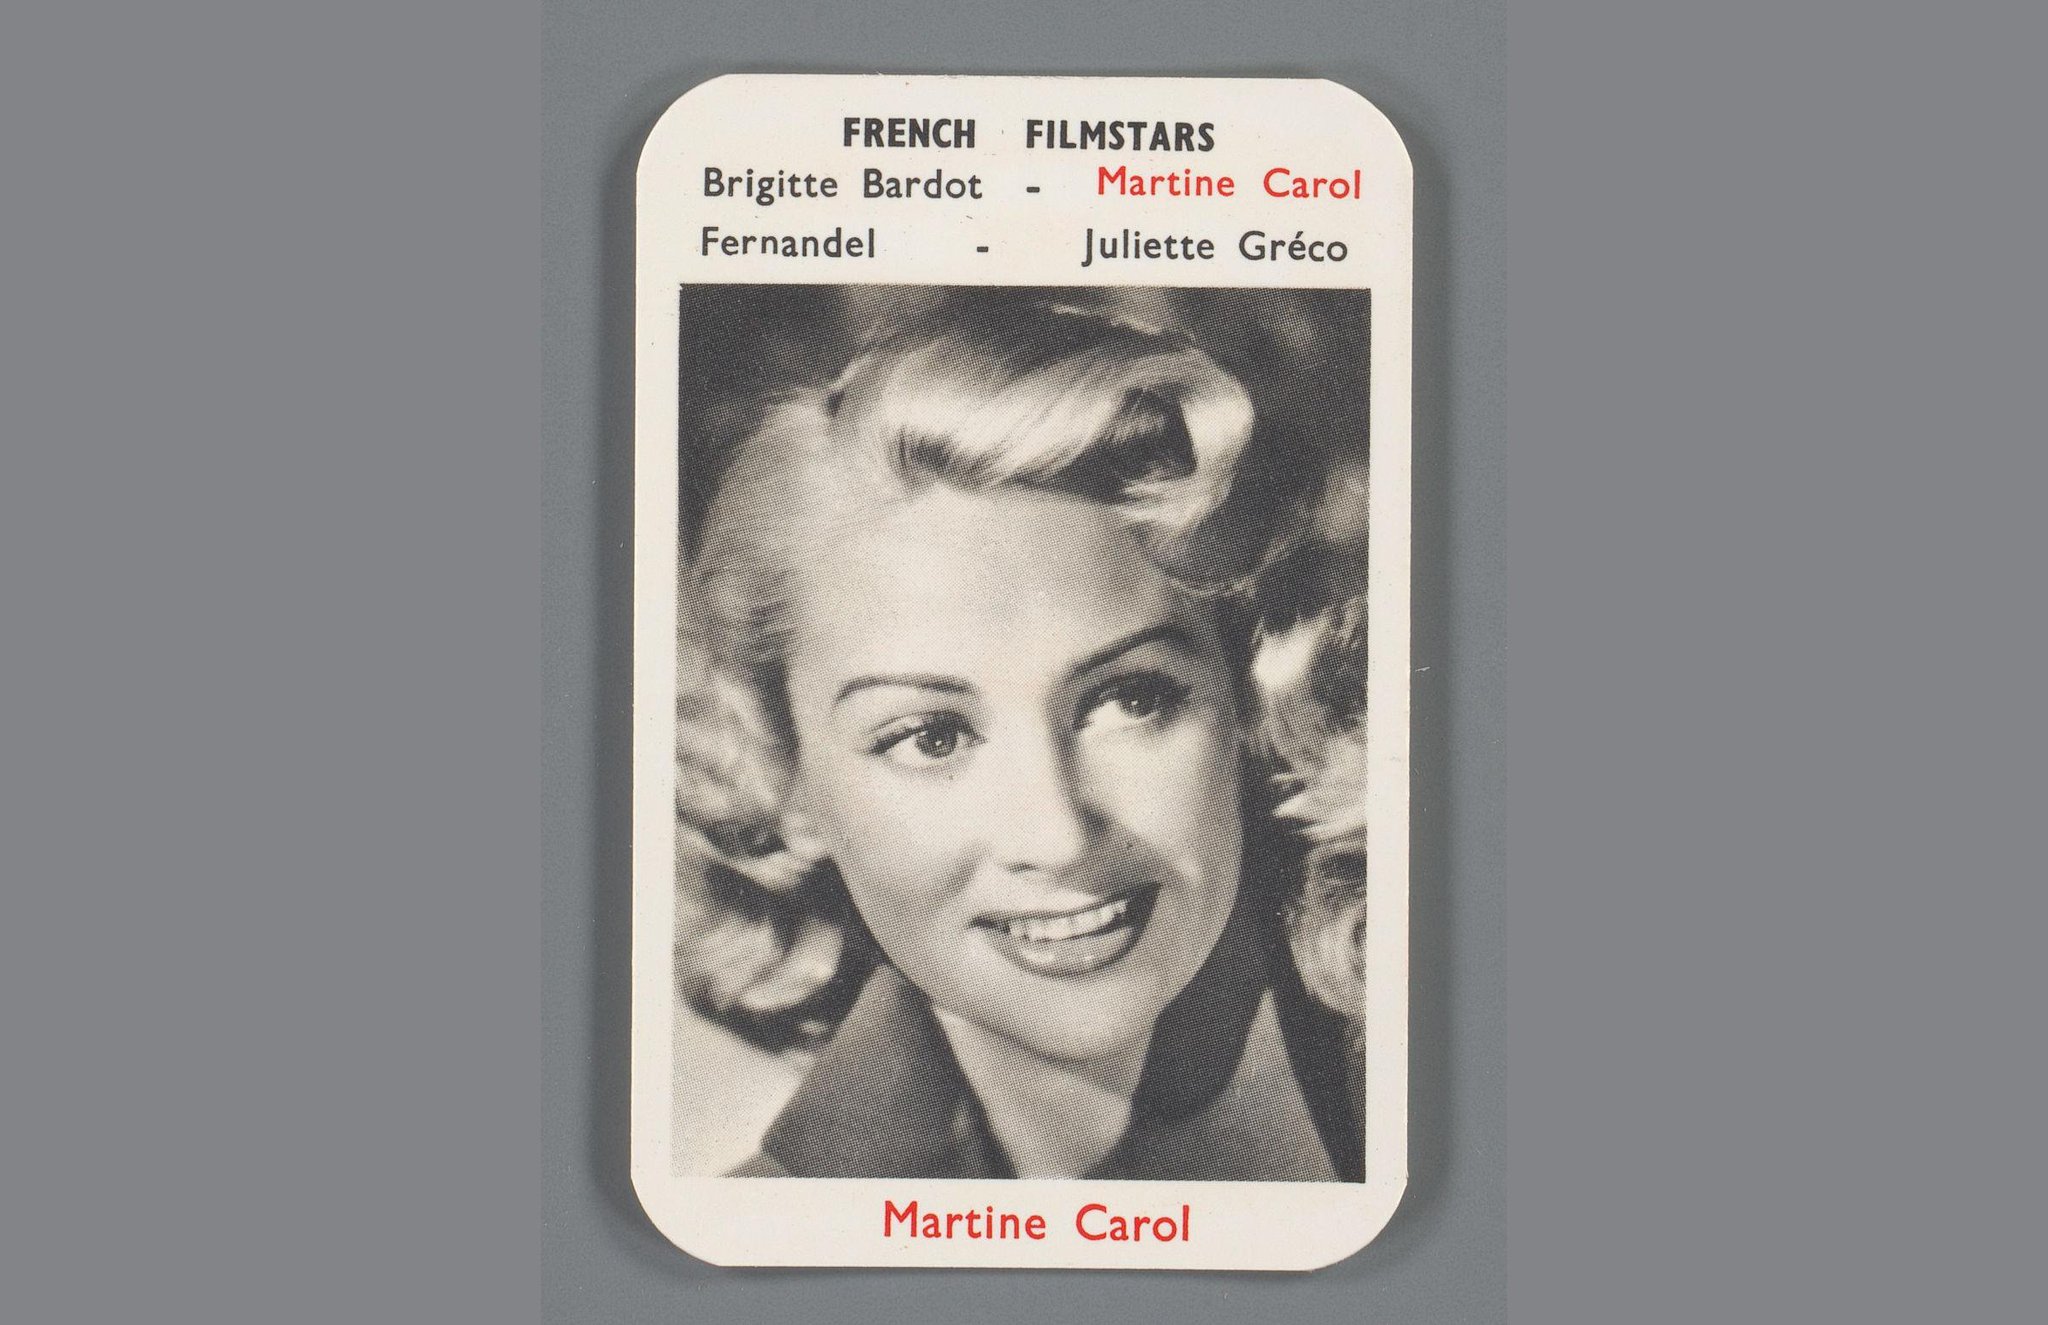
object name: photomechanical print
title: Portret van Martine Carol; onderdeel van het kwartet French Filmstars uit een kwartetspel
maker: Anonymous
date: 1960-1970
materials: paper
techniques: autotype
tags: portrait of actor, actress